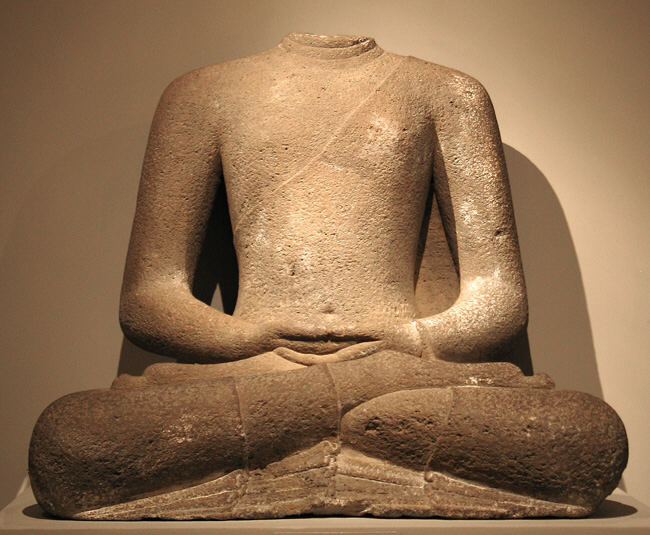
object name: headless figure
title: Seated Buddha Amitabha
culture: indonesian, javanese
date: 801-850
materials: stone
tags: buddhism,buddha